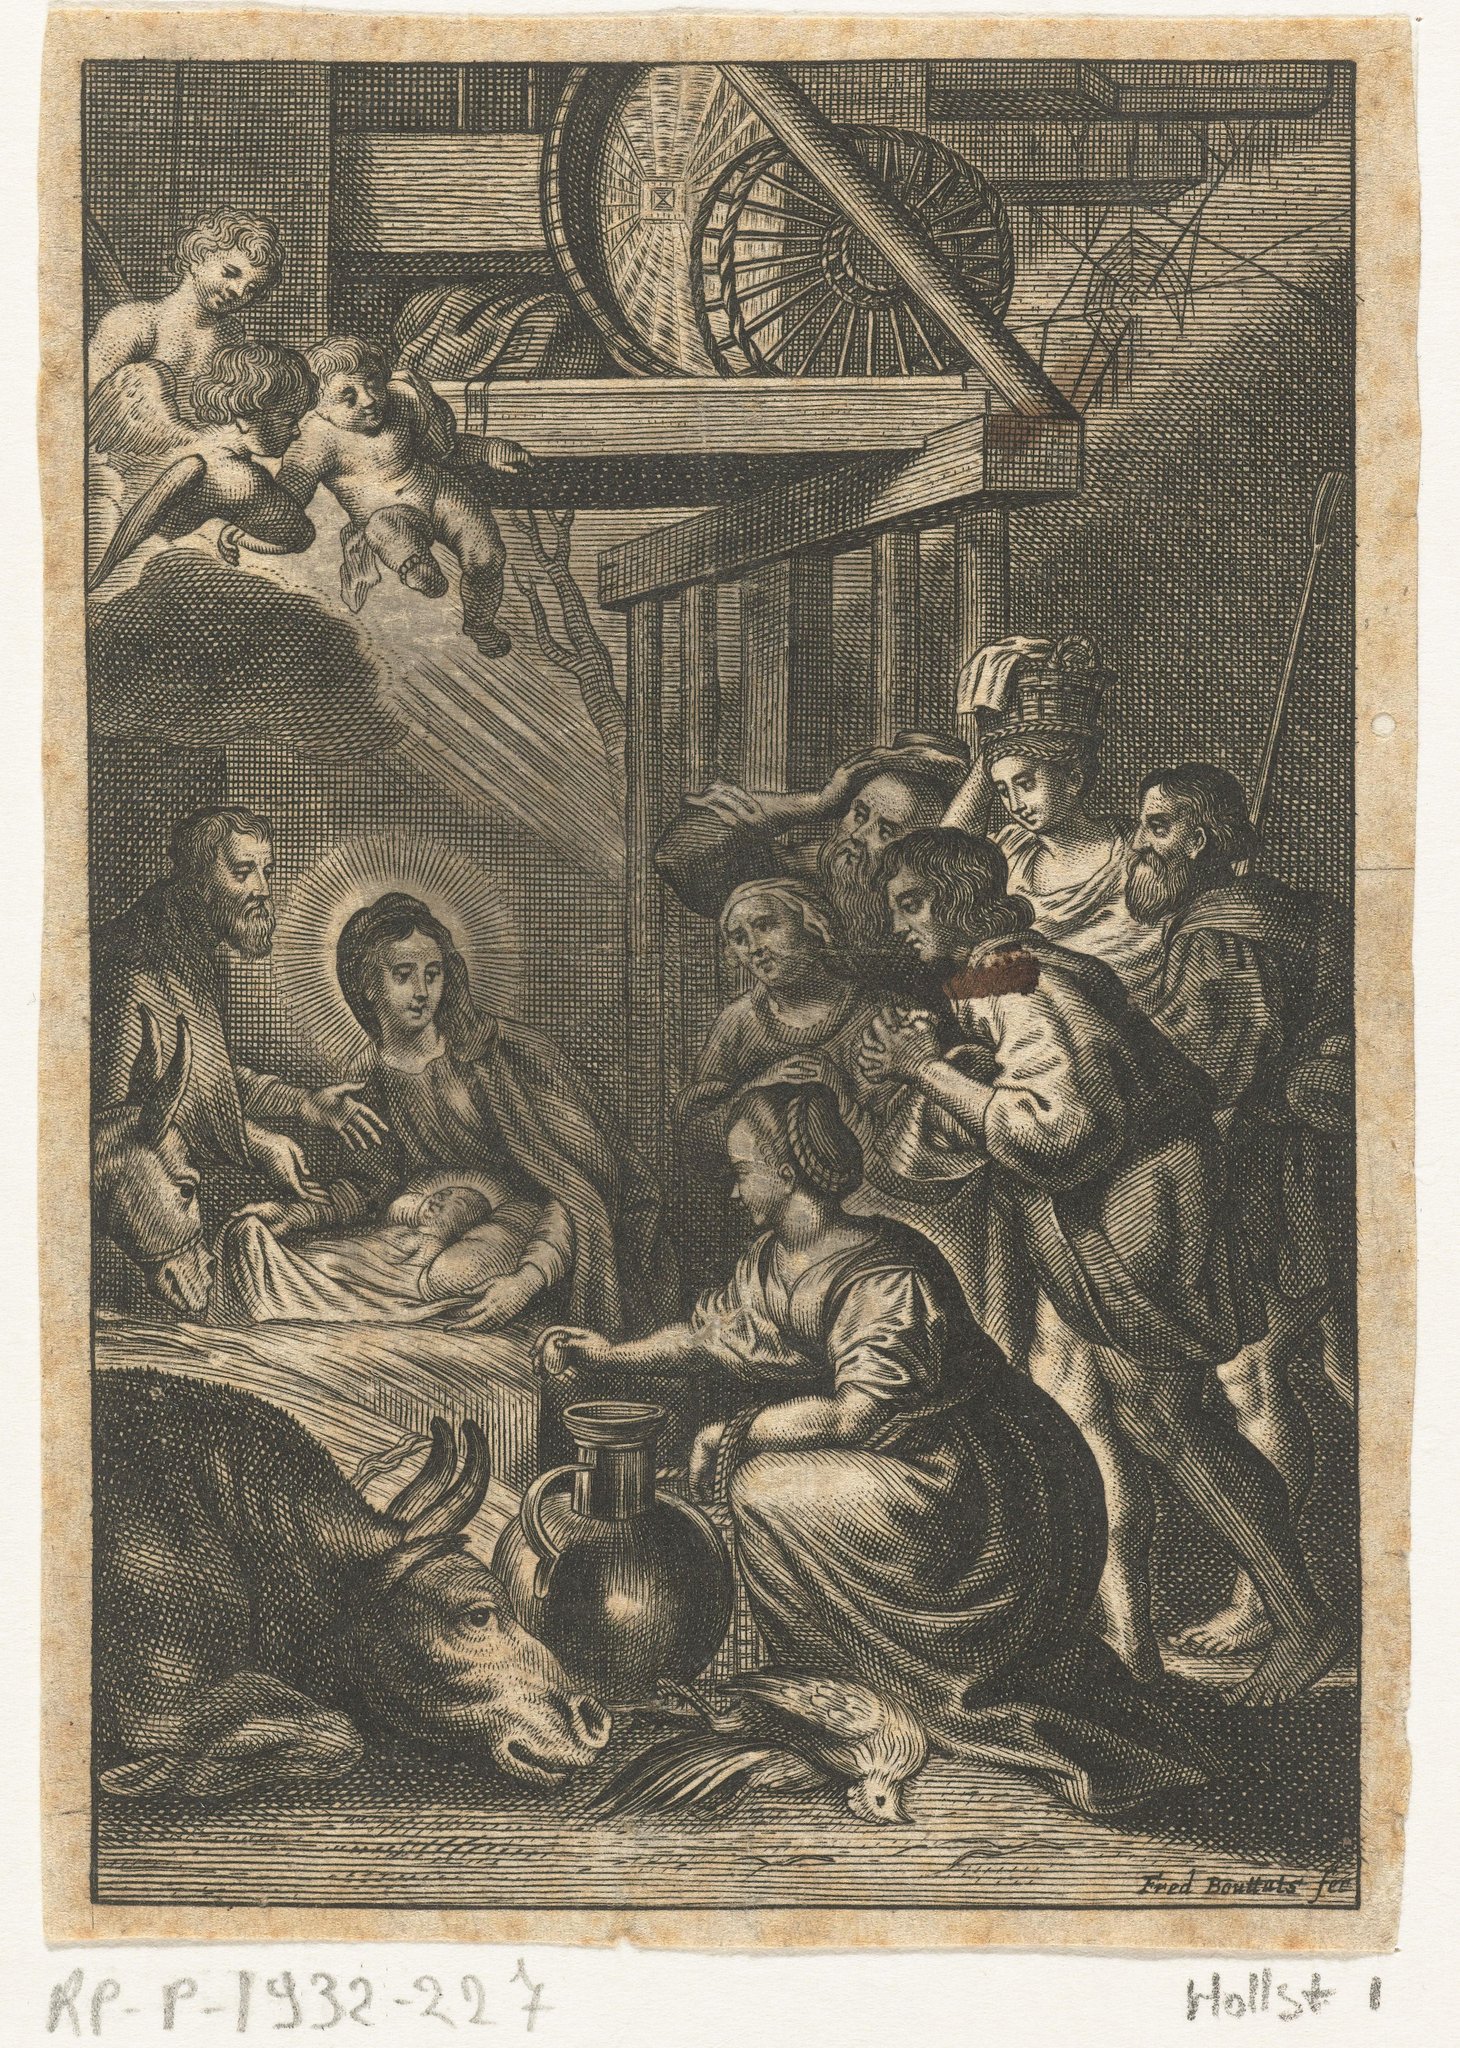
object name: print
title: Aanbidding door de herders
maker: frederik bouttats (i)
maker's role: artist, painter, print maker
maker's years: 1590-1661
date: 1600-1661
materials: paper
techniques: engraving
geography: antwerp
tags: adoration of the christ-child by the shepherds; mary and joseph present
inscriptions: collector's mark: Lugt 2228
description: Een groep herders (en hun vrouwen) bezoeken de Heilige Familie in de stal en knielen voor het Christuskind. In de linkerbovenhoek zijn enkele engelen aanwezig. Op de voorgrond liggen de os en de ezel.